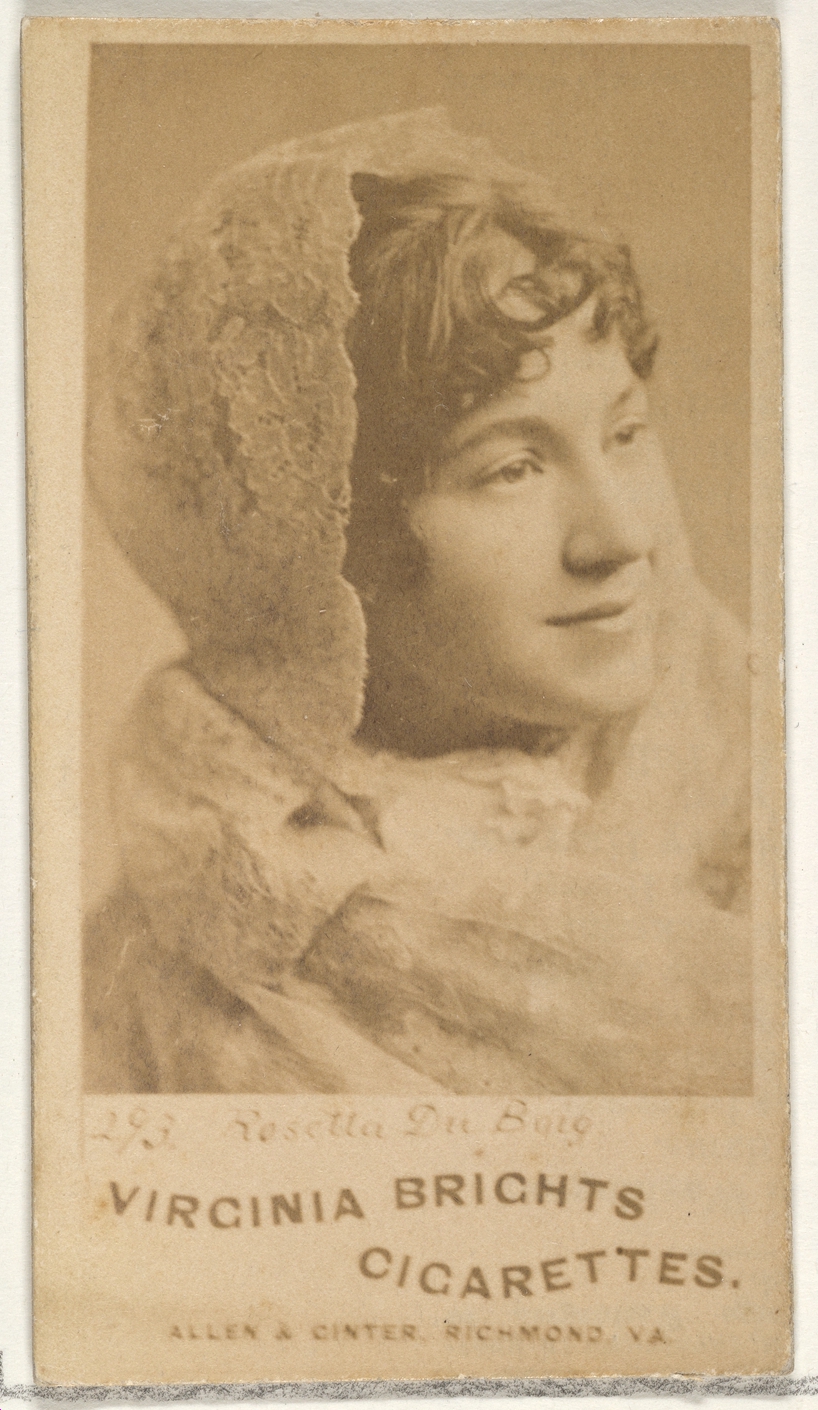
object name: photograph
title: Card 293, Rosetta du Buig, from the Actors and Actresses series (N45, Type 1) for Virginia Brights Cigarettes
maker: allen & ginter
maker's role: publisher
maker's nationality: american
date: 1888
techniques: albumen silver print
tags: portraits,women,actresses